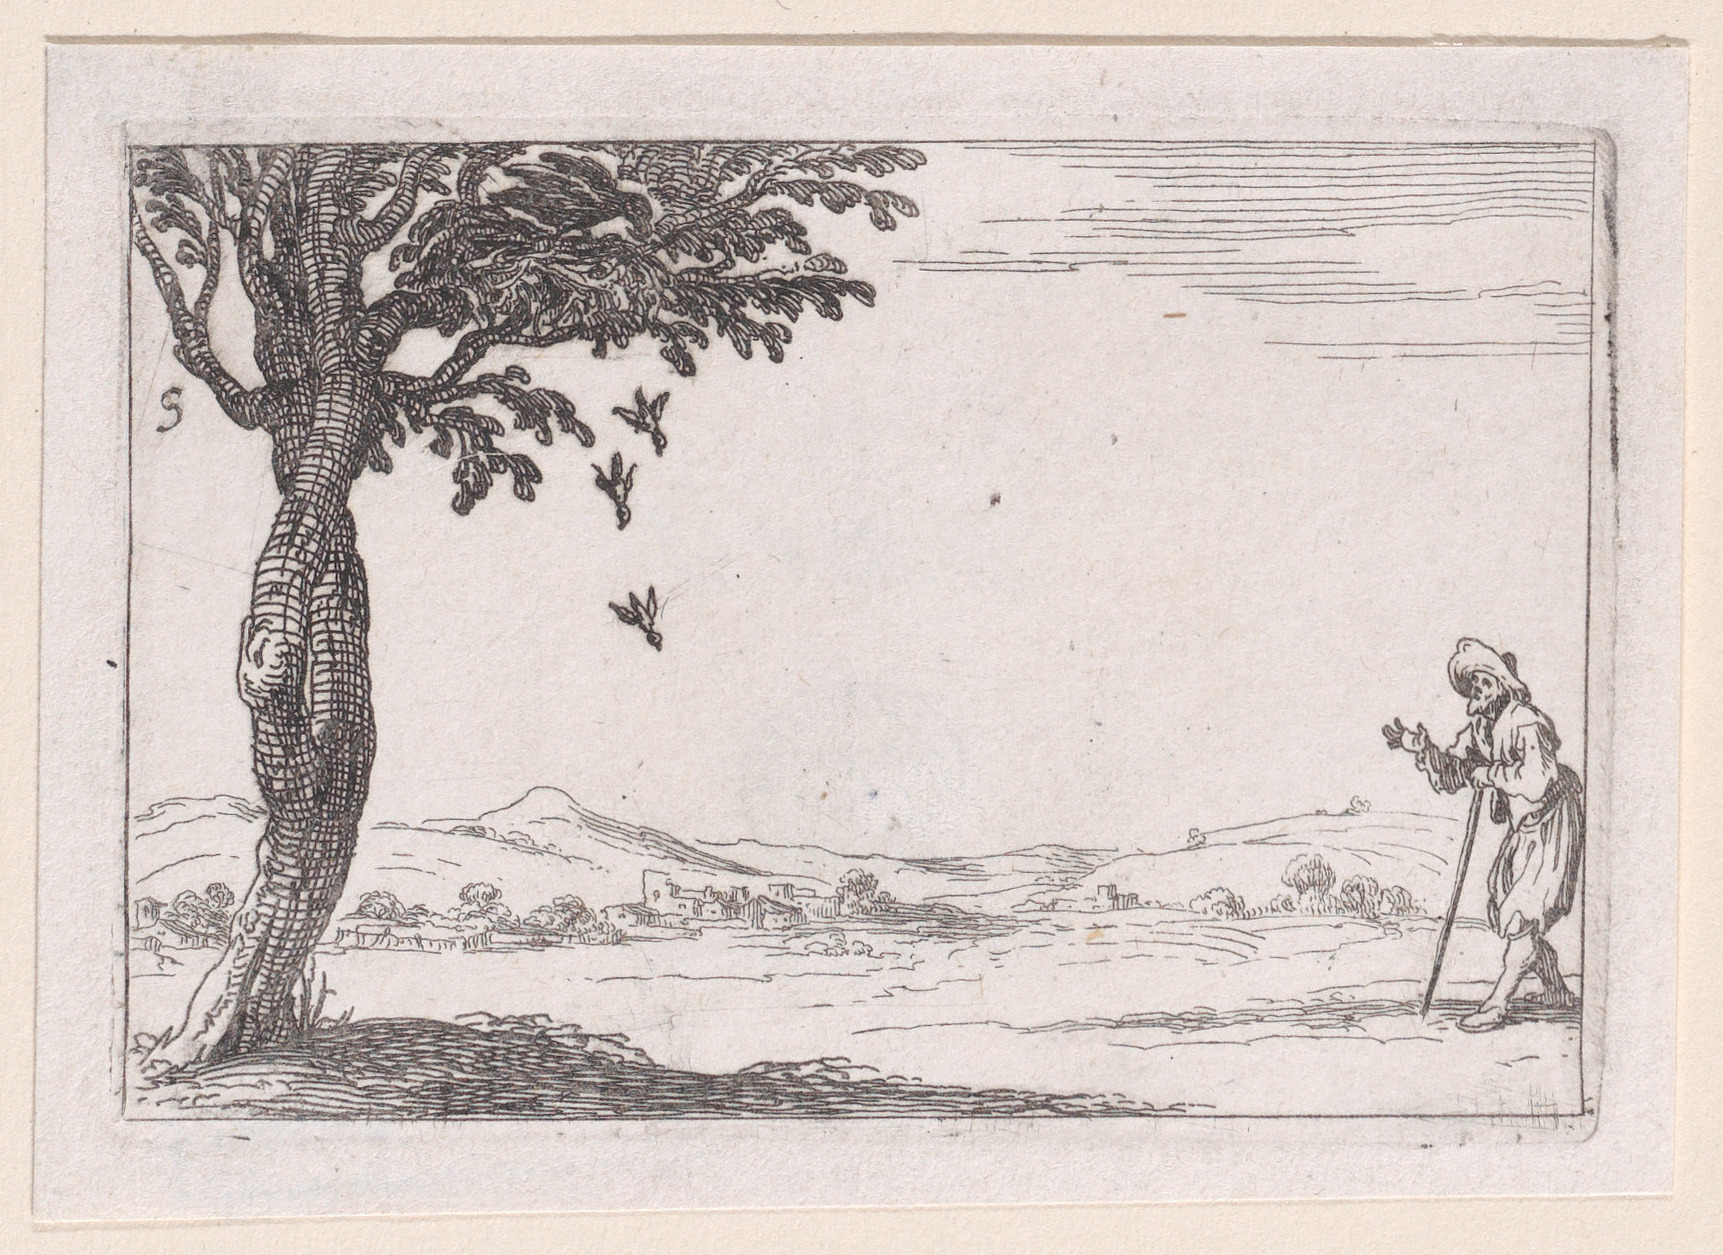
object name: print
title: Le Corbeau et ses Petits (The Raven and his Young), plate 5 from "Lux Claustri ou La Lumière du Cloitre" (The Light of the Cloisters)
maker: jacques callot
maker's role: artist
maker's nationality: french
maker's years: 1592-1635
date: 1621-1635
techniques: etching